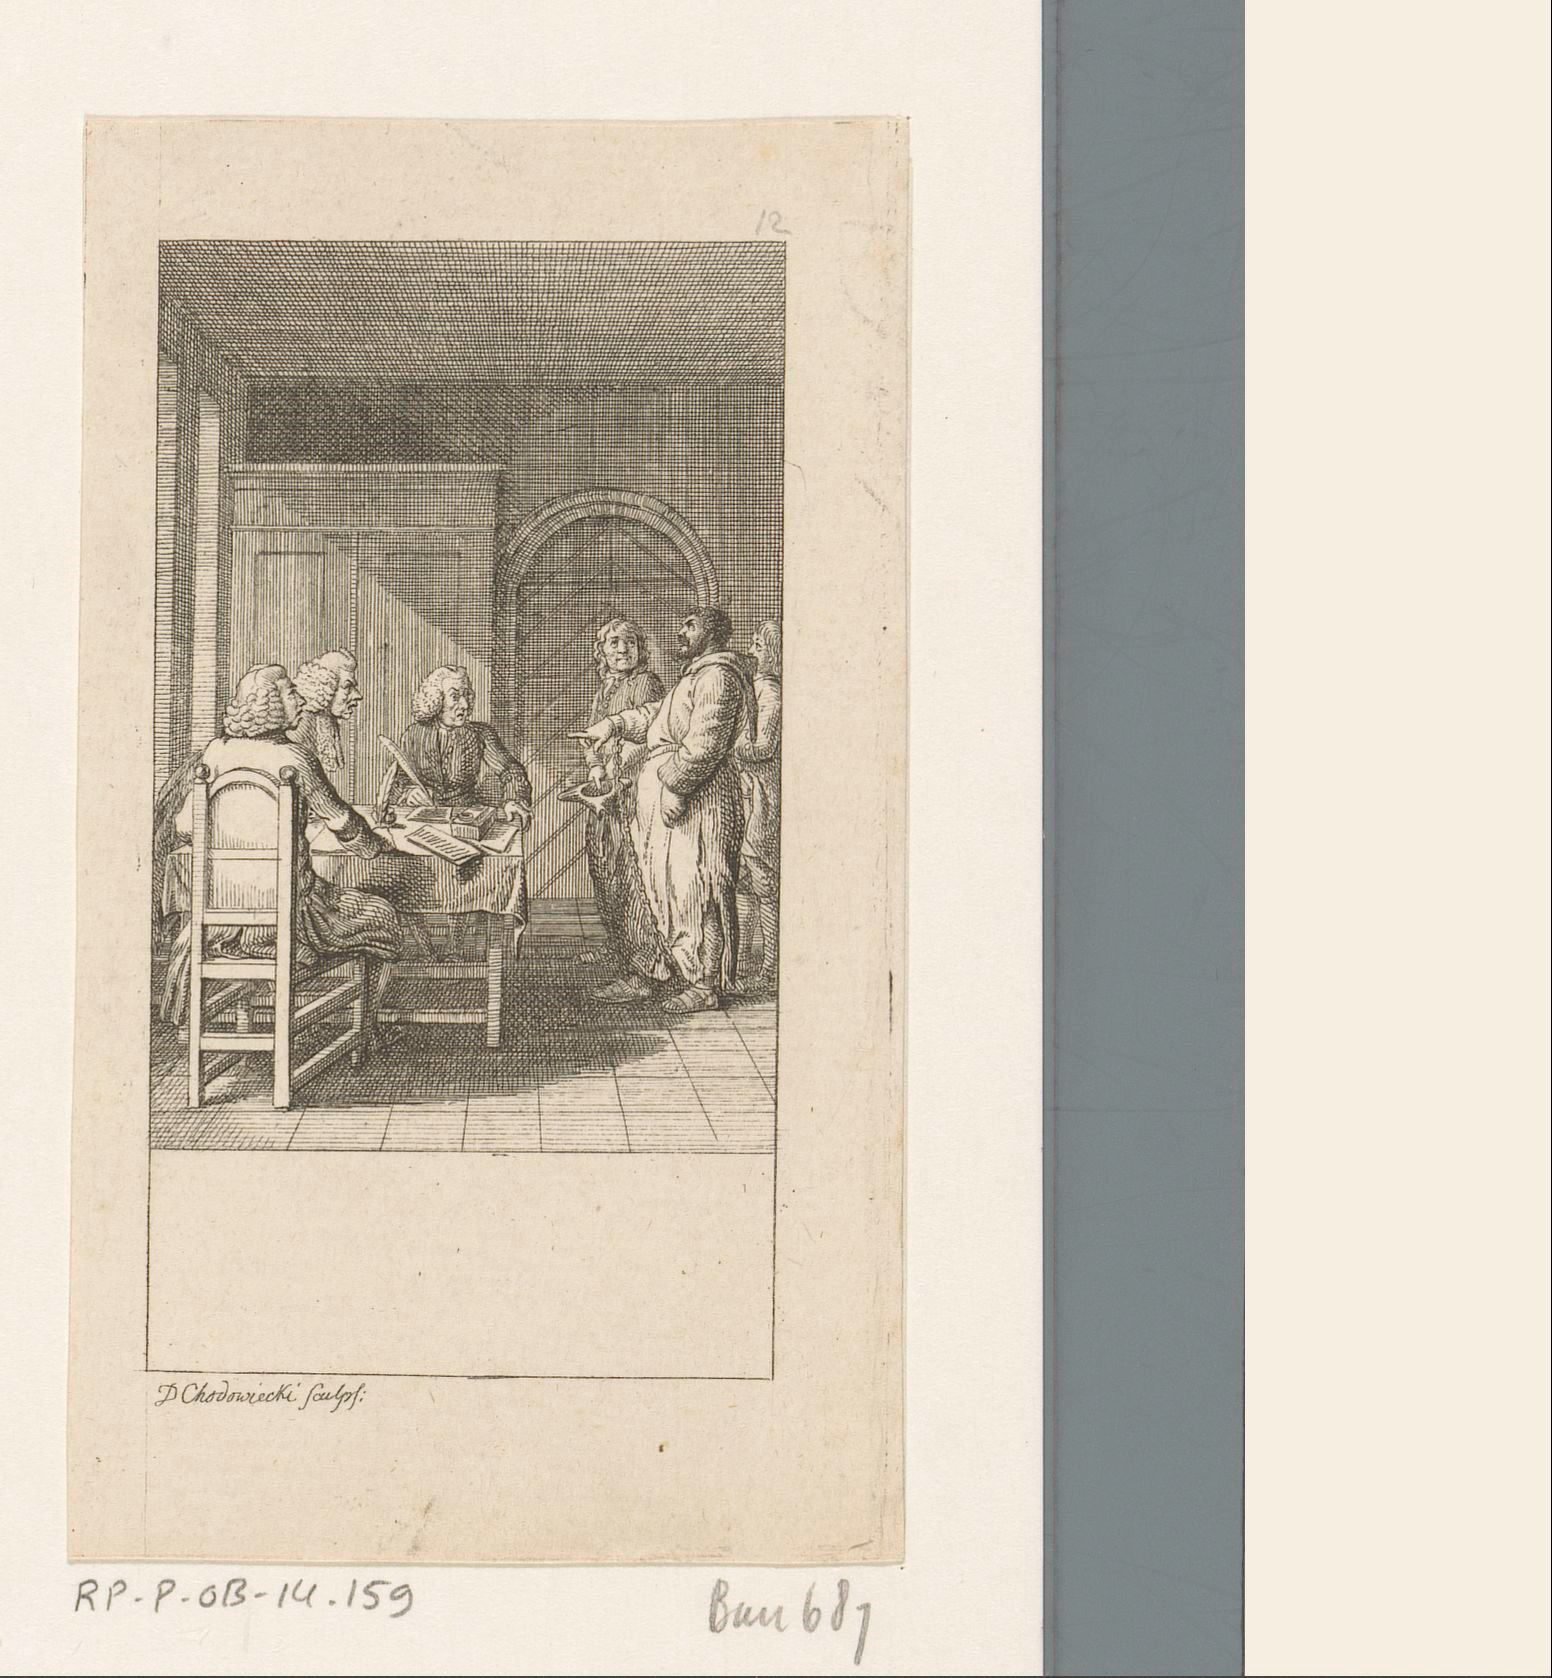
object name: print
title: Jonge heremiet voor de rechter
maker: daniel nikolaus chodowiecki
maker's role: draughtsman, print maker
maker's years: 1726-1801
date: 1779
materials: paper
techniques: etching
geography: berlin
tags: literature, anchorite, hermit, court-room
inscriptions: collector's mark: Lugt 2228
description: Twaalfde prent uit een serie van twaalf prenten die de 'Fabeln und Erzählungen' van Gotthold Ephraim Lessing illustreren. De scènes werden op een plaat geëtst. Een latere staat van deze serie is ook gebruikt in: Almanac de Gotha contenant diverses connoissances curieuses et utiles pour l'annee 1780. Gotha, C.W. Ettinger.